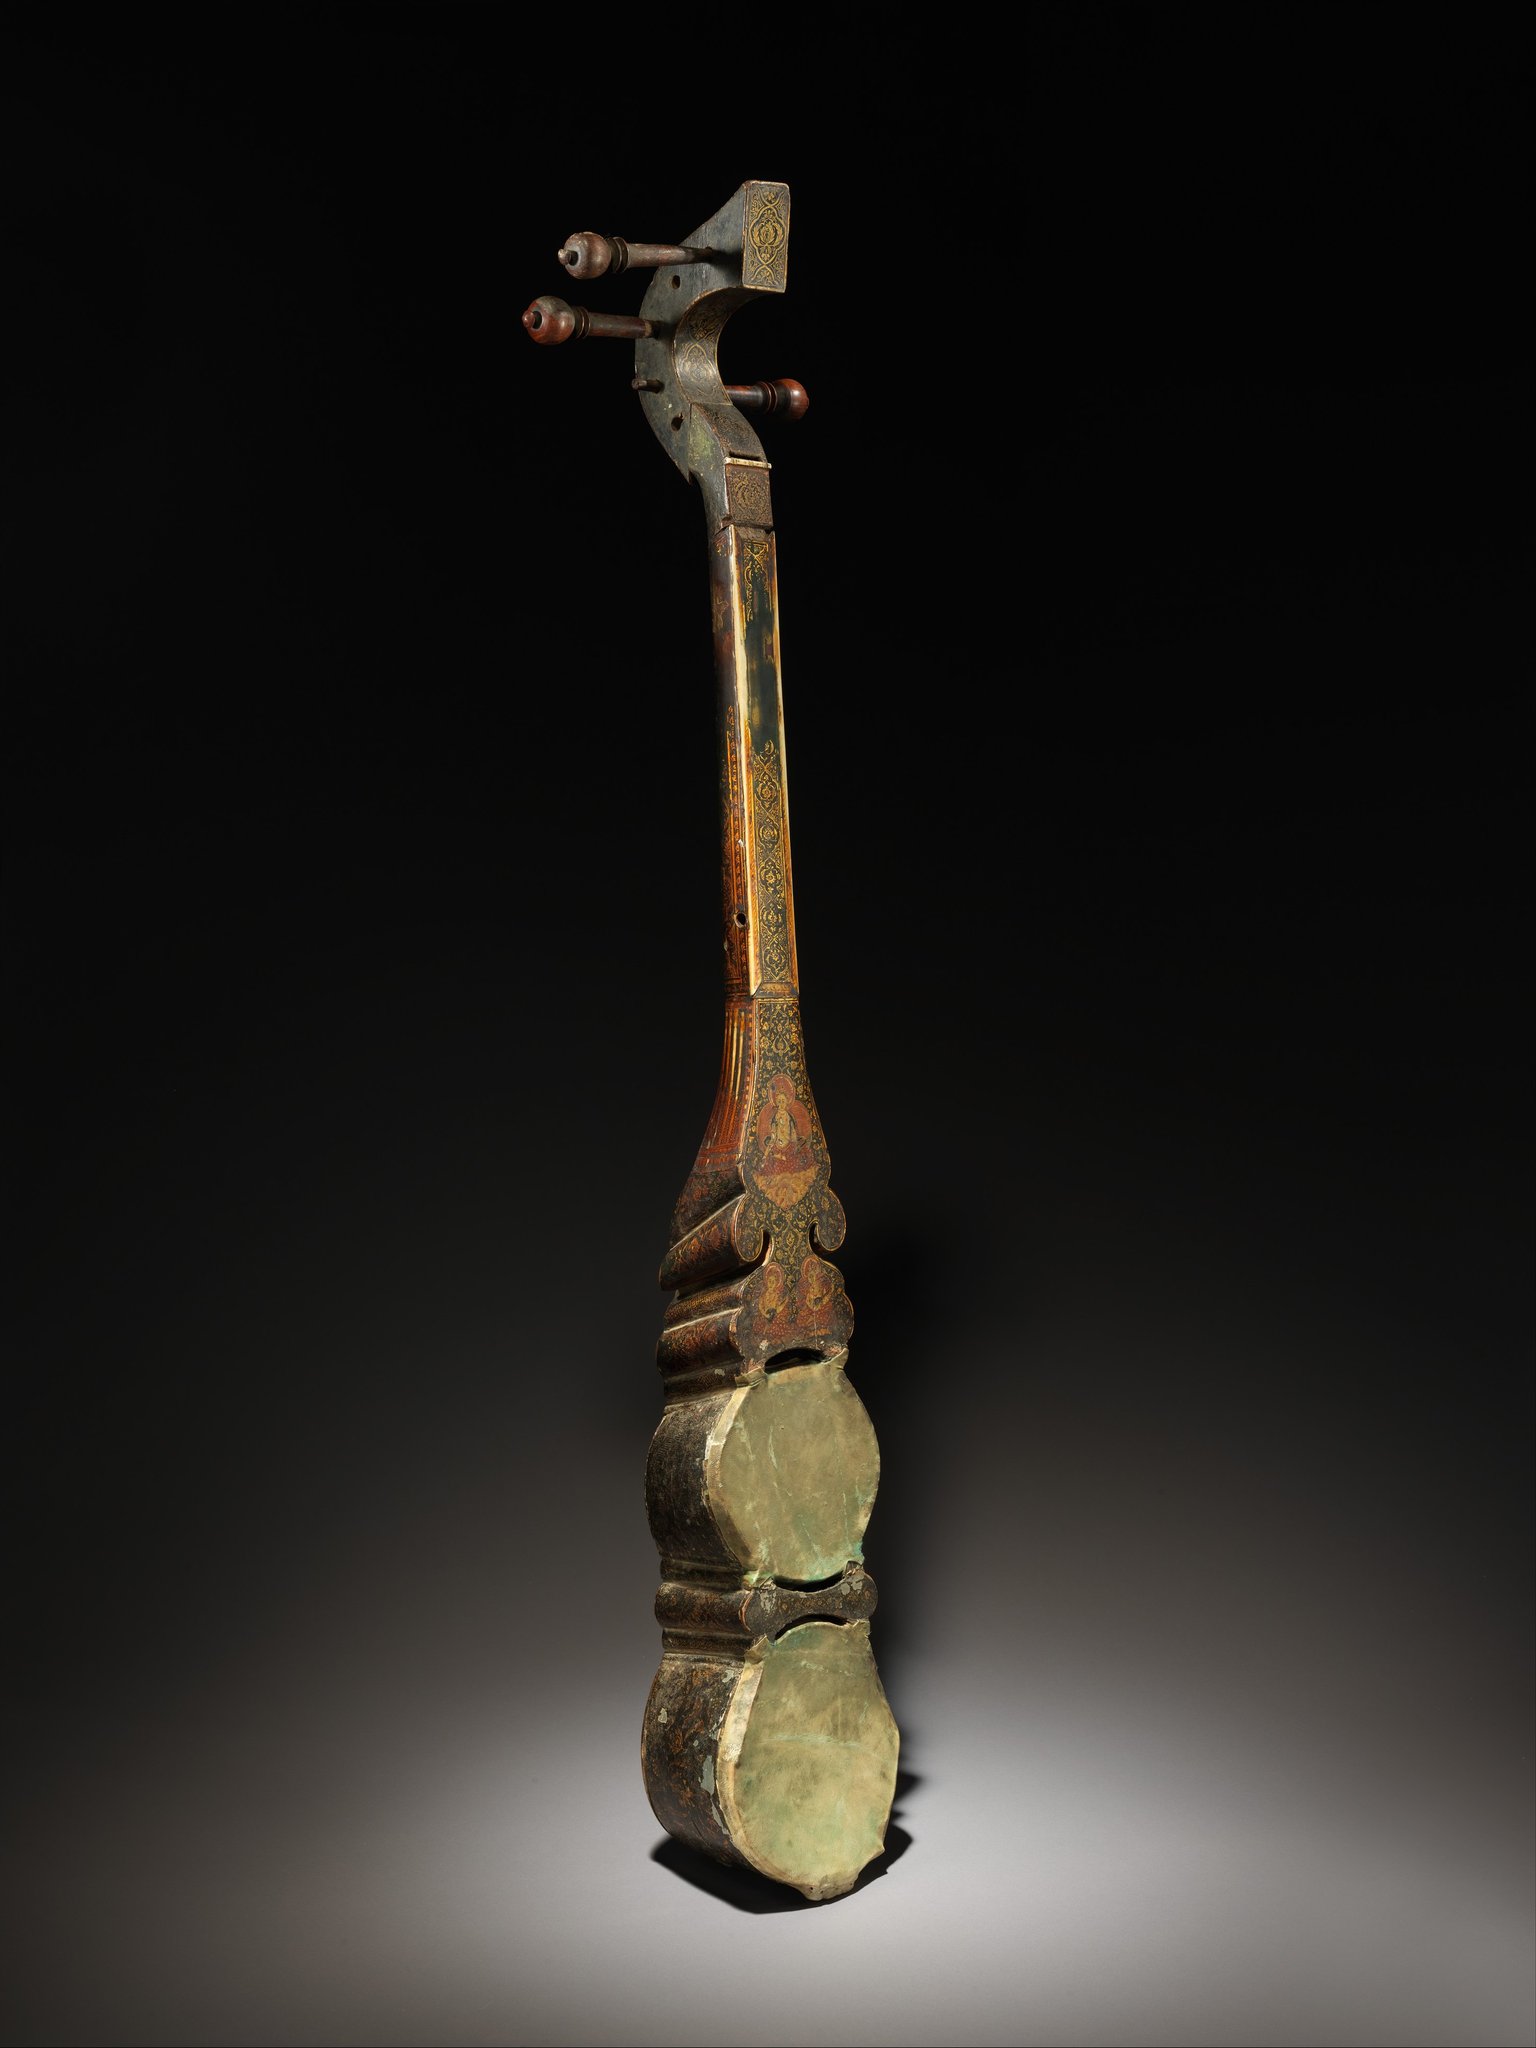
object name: sgra snyan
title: Sgra-Snyan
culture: tibetan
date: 1301-1600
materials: gesso, skin, wood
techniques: carving, gilding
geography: tibet